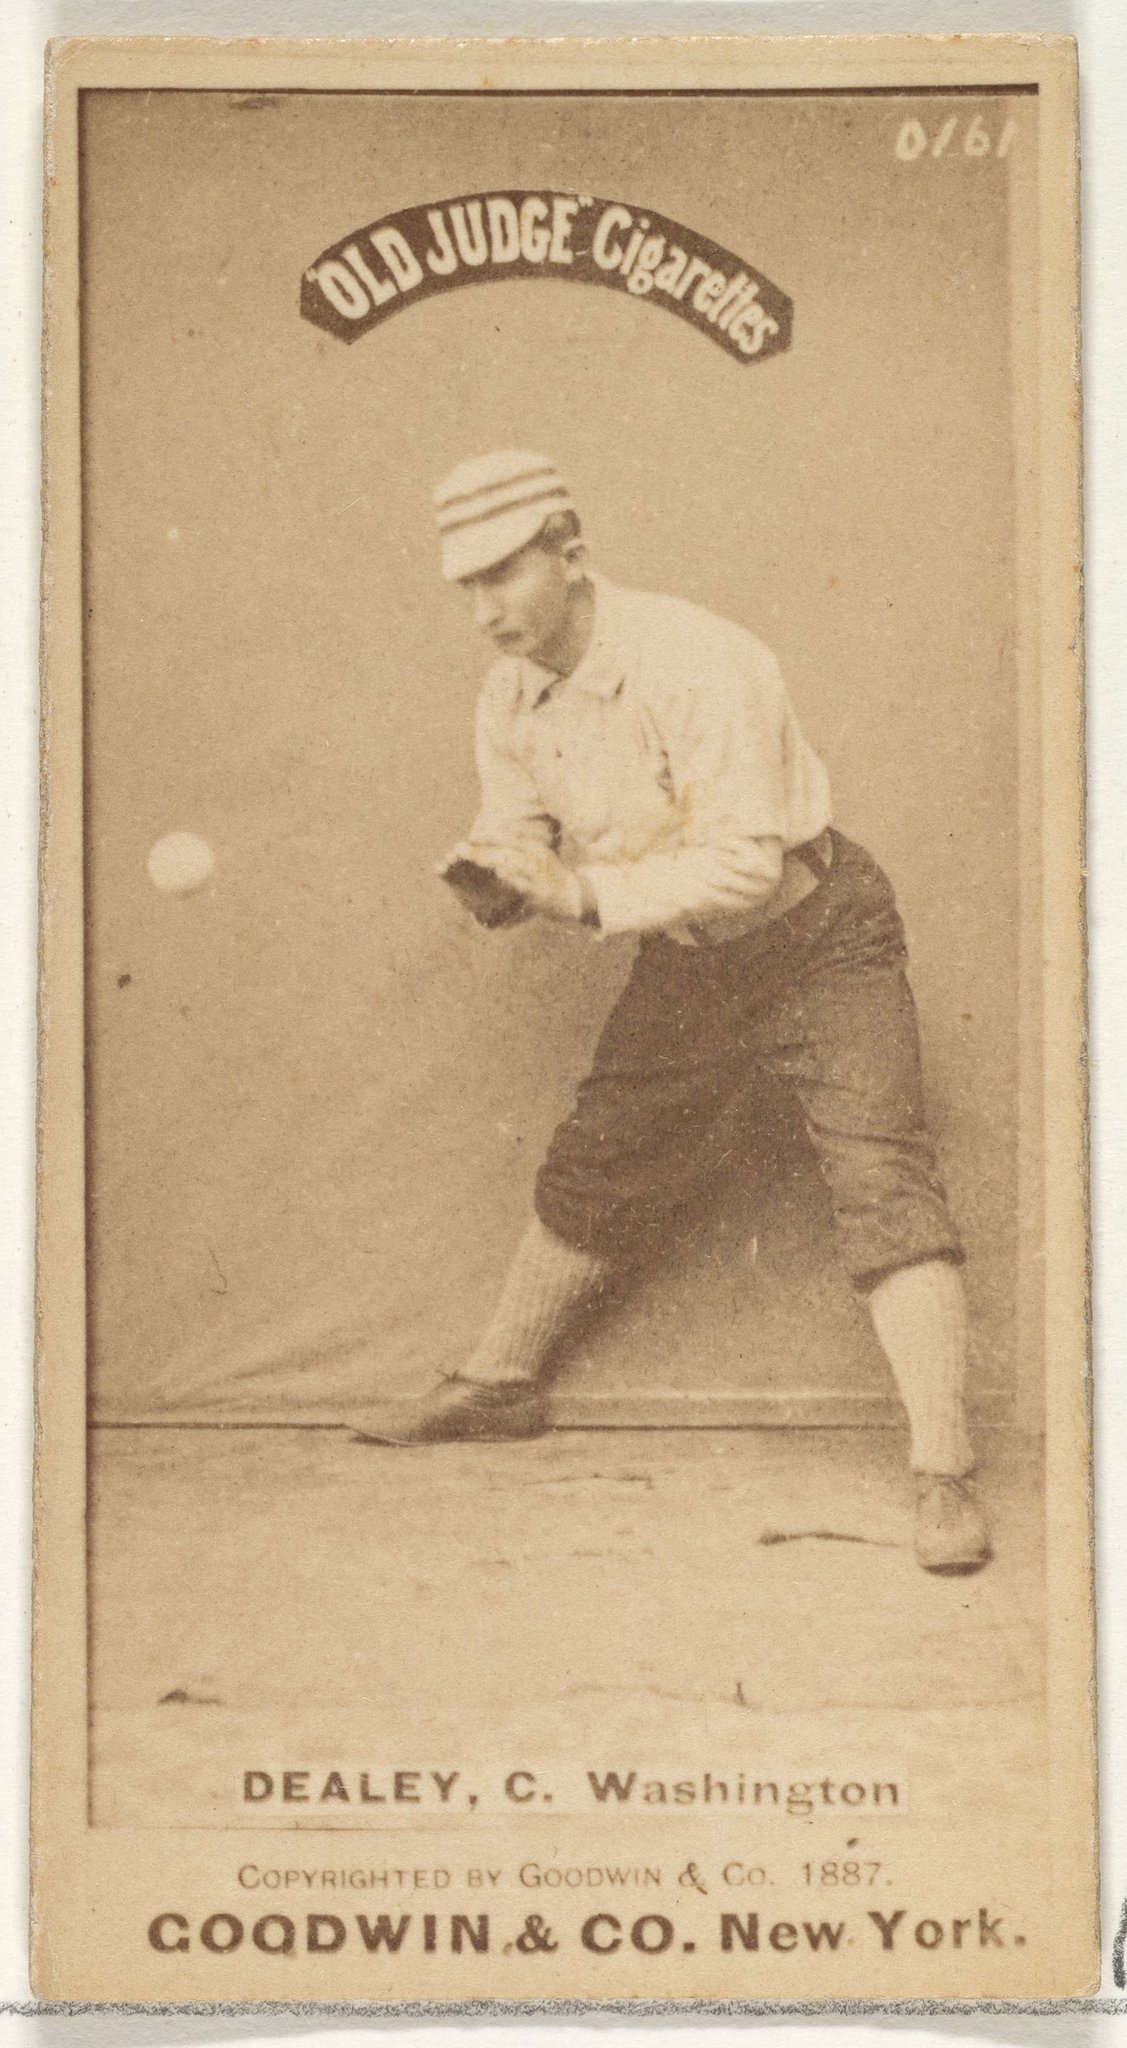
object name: baseball card, photograph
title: Patrick "Pat" E. Dealy, Catcher, Washington Nationals, from the Old Judge series (N172) for Old Judge Cigarettes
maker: goodwin & company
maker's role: publisher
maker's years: 1850-1950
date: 1887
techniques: albumen silver print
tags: men,portraits,baseball,athletes